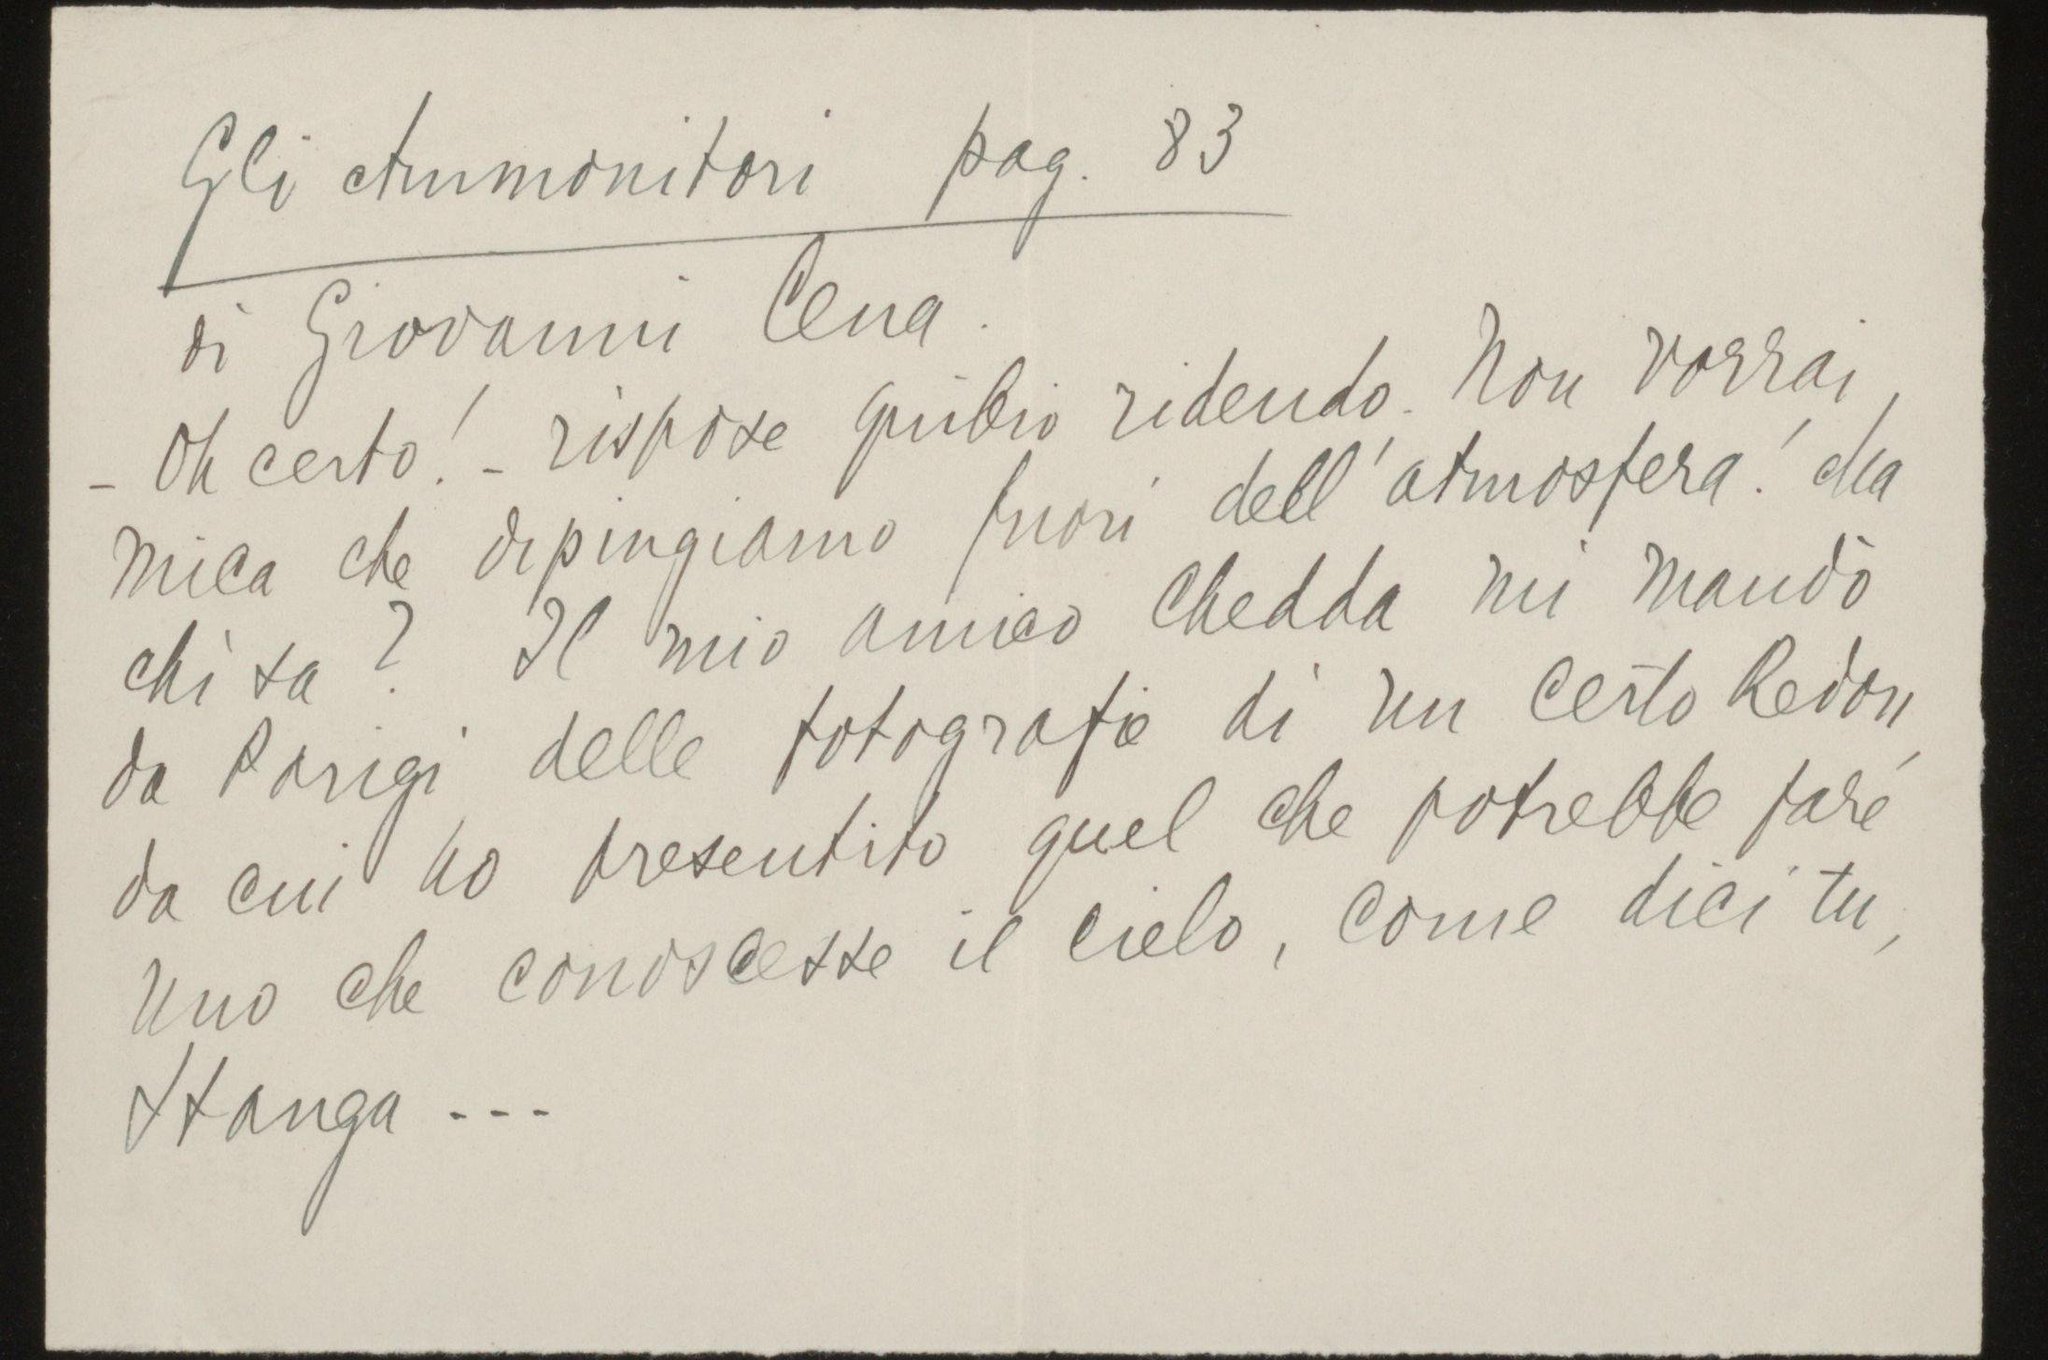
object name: aantekening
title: Aantekening Gli Ammonitori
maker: Anonymous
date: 1897-1975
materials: ink, paper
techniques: pen, writing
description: Aantekening behoort tot een album samengesteld door weduwe Françoise W.M. Barones van der Borch van Verwolde met afschriften van brieven met betrekking tot (de familie van) Odilon Redon. De aantekening werd bewaard op pagina 96.